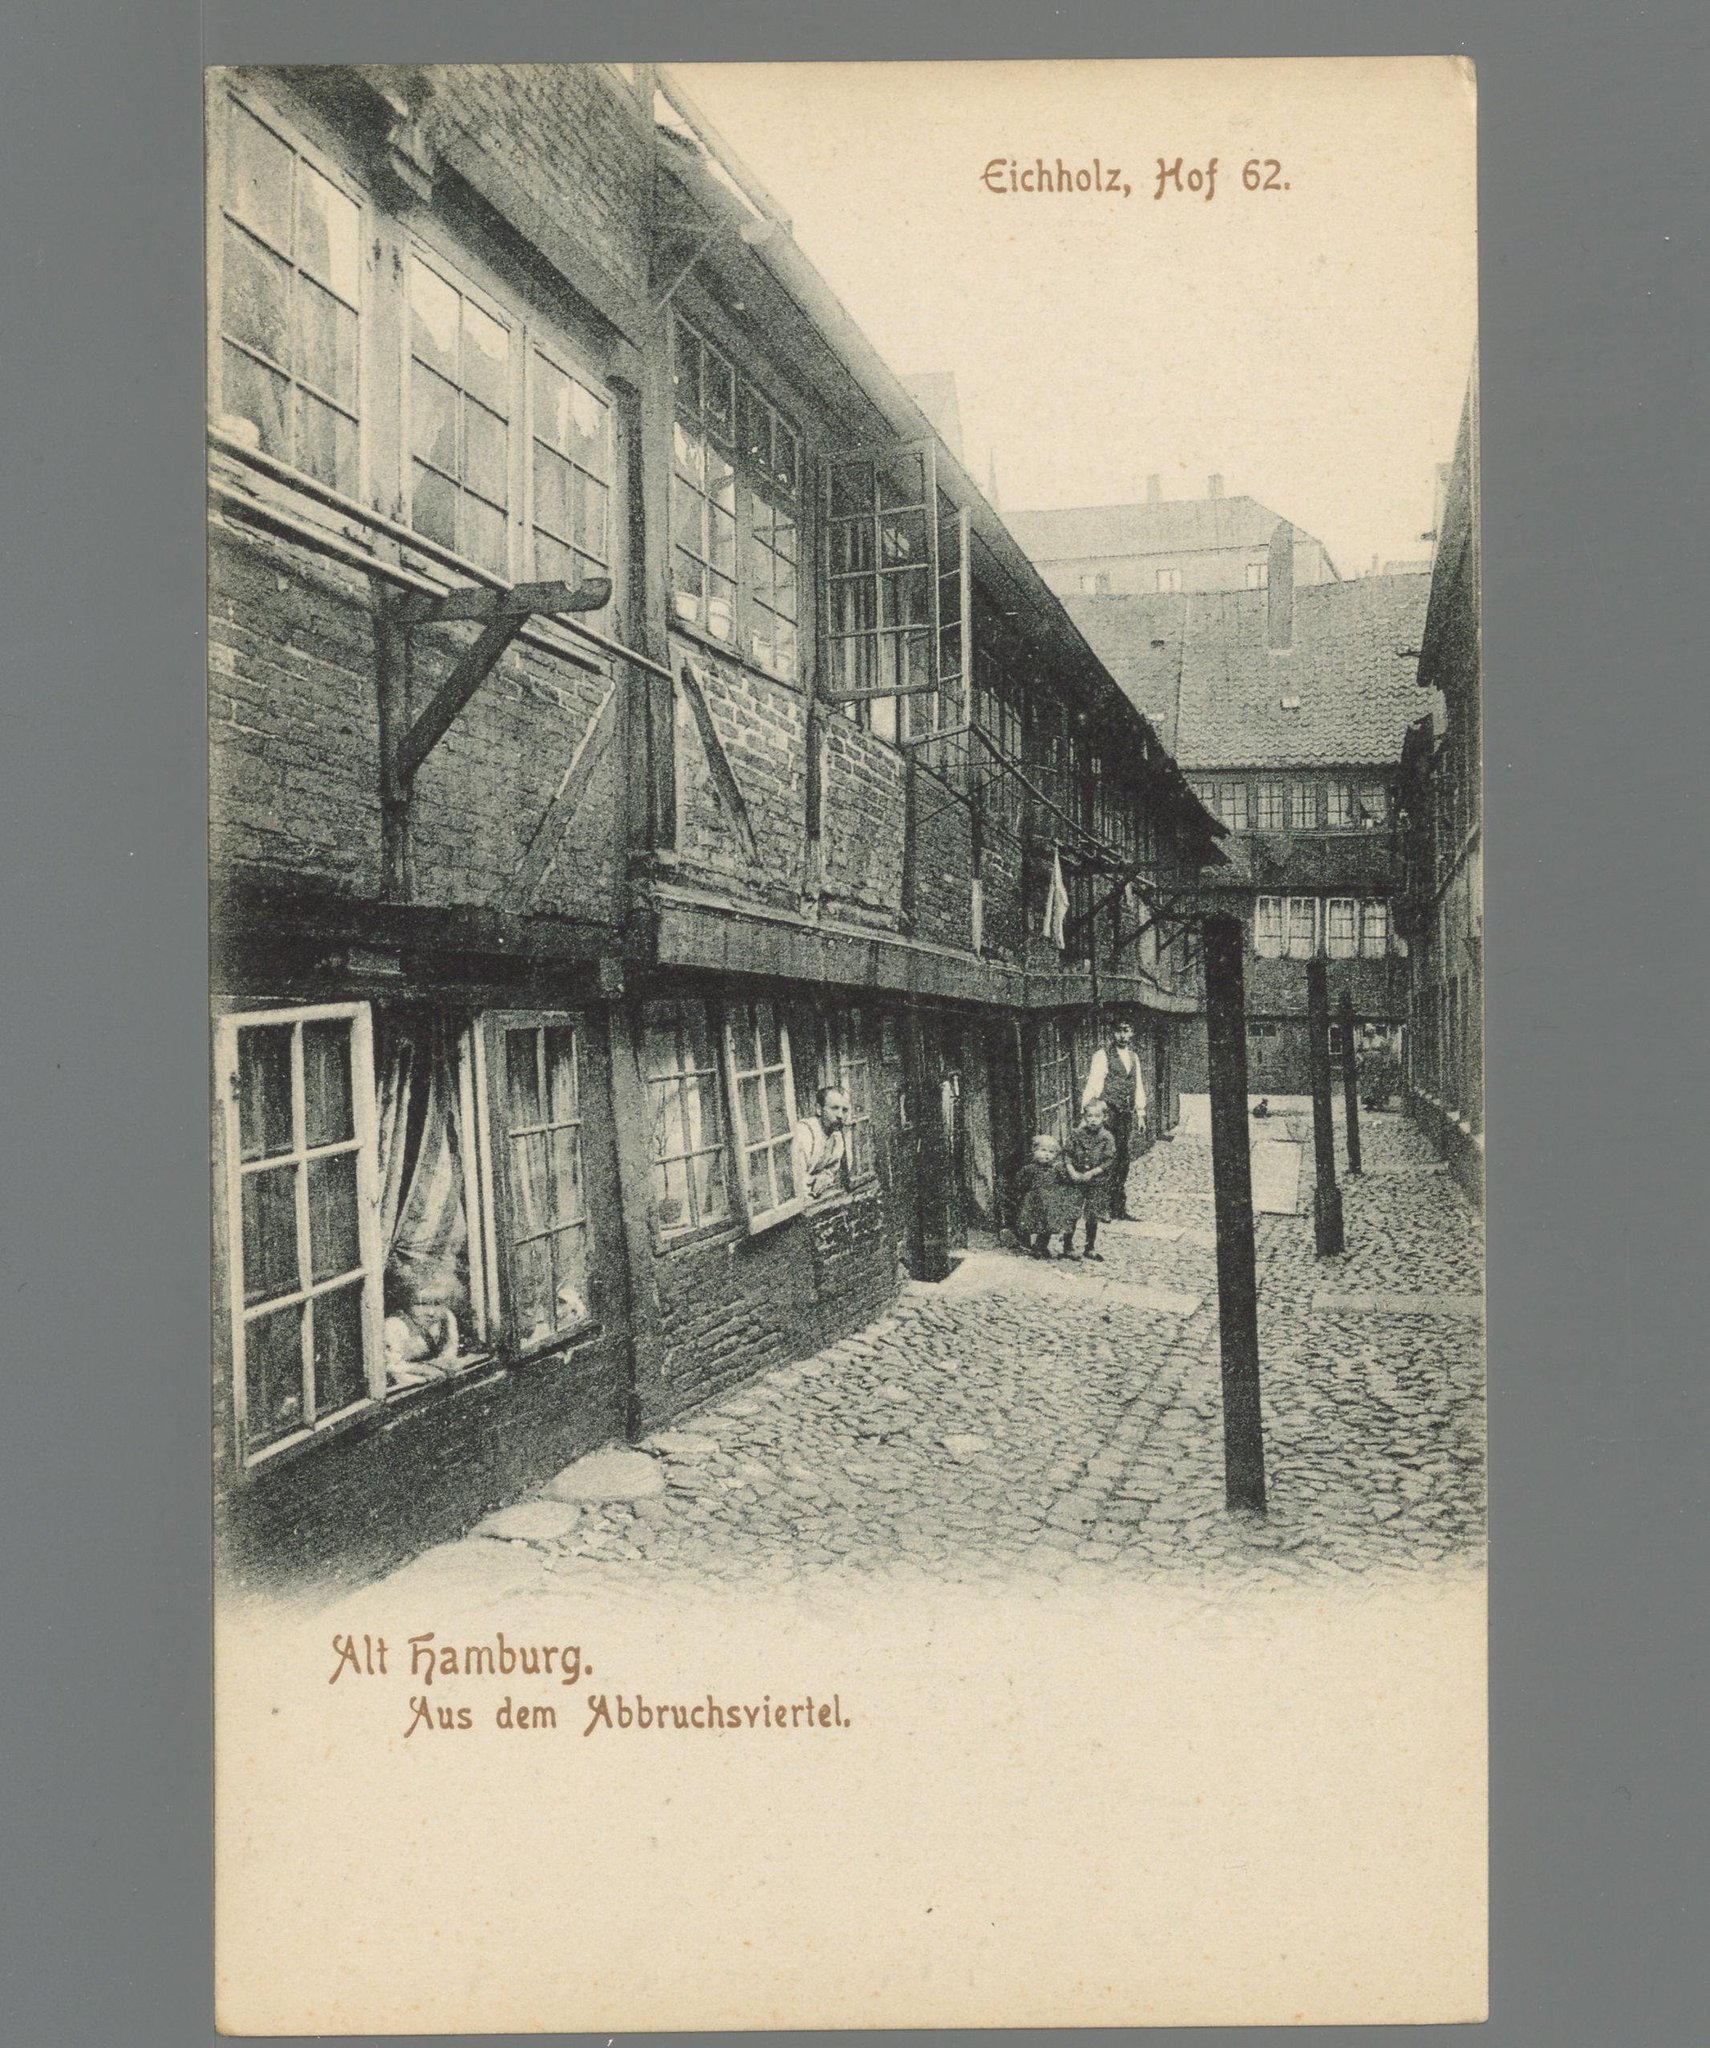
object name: photomechanical print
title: Alt Hamburg. Aus dem Abbruchsviertel. Eichholz, Hof 62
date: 1905-1930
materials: cardboard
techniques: photograph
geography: hamburg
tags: street